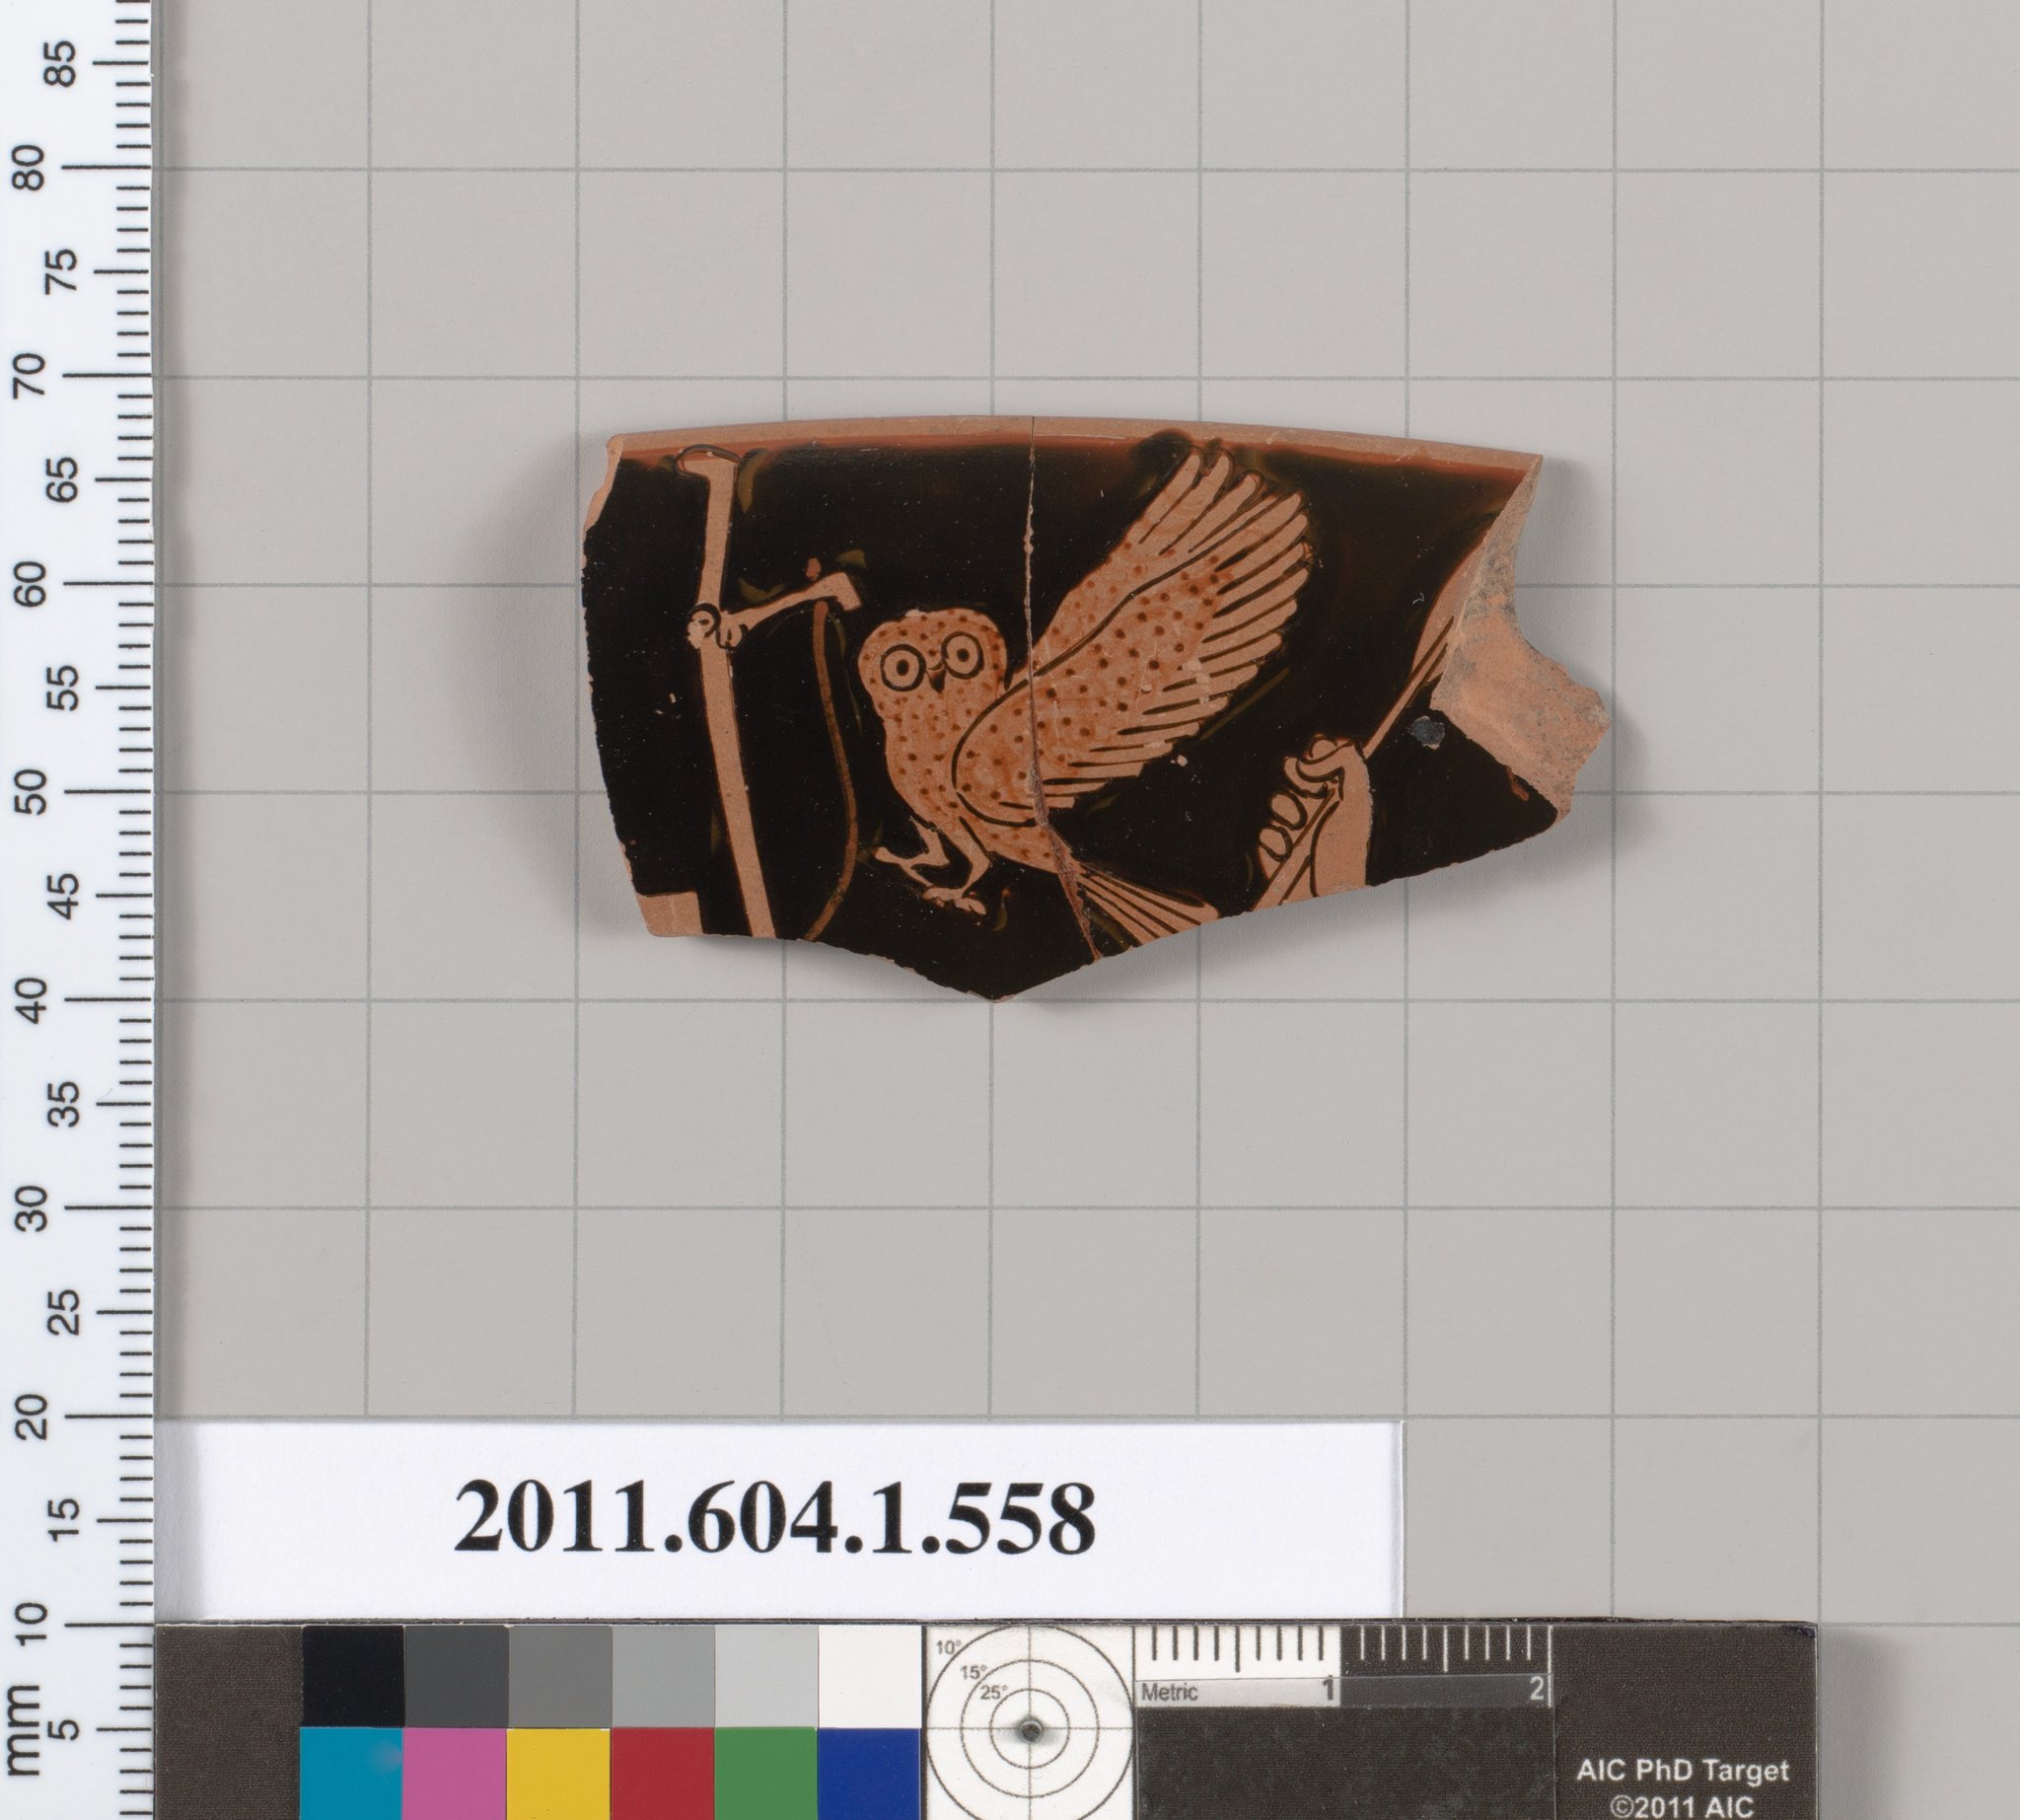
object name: kylix fragment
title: Terracotta rim fragment of a kylix (drinking cup)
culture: greek, attic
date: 480-470 BCE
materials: terracotta